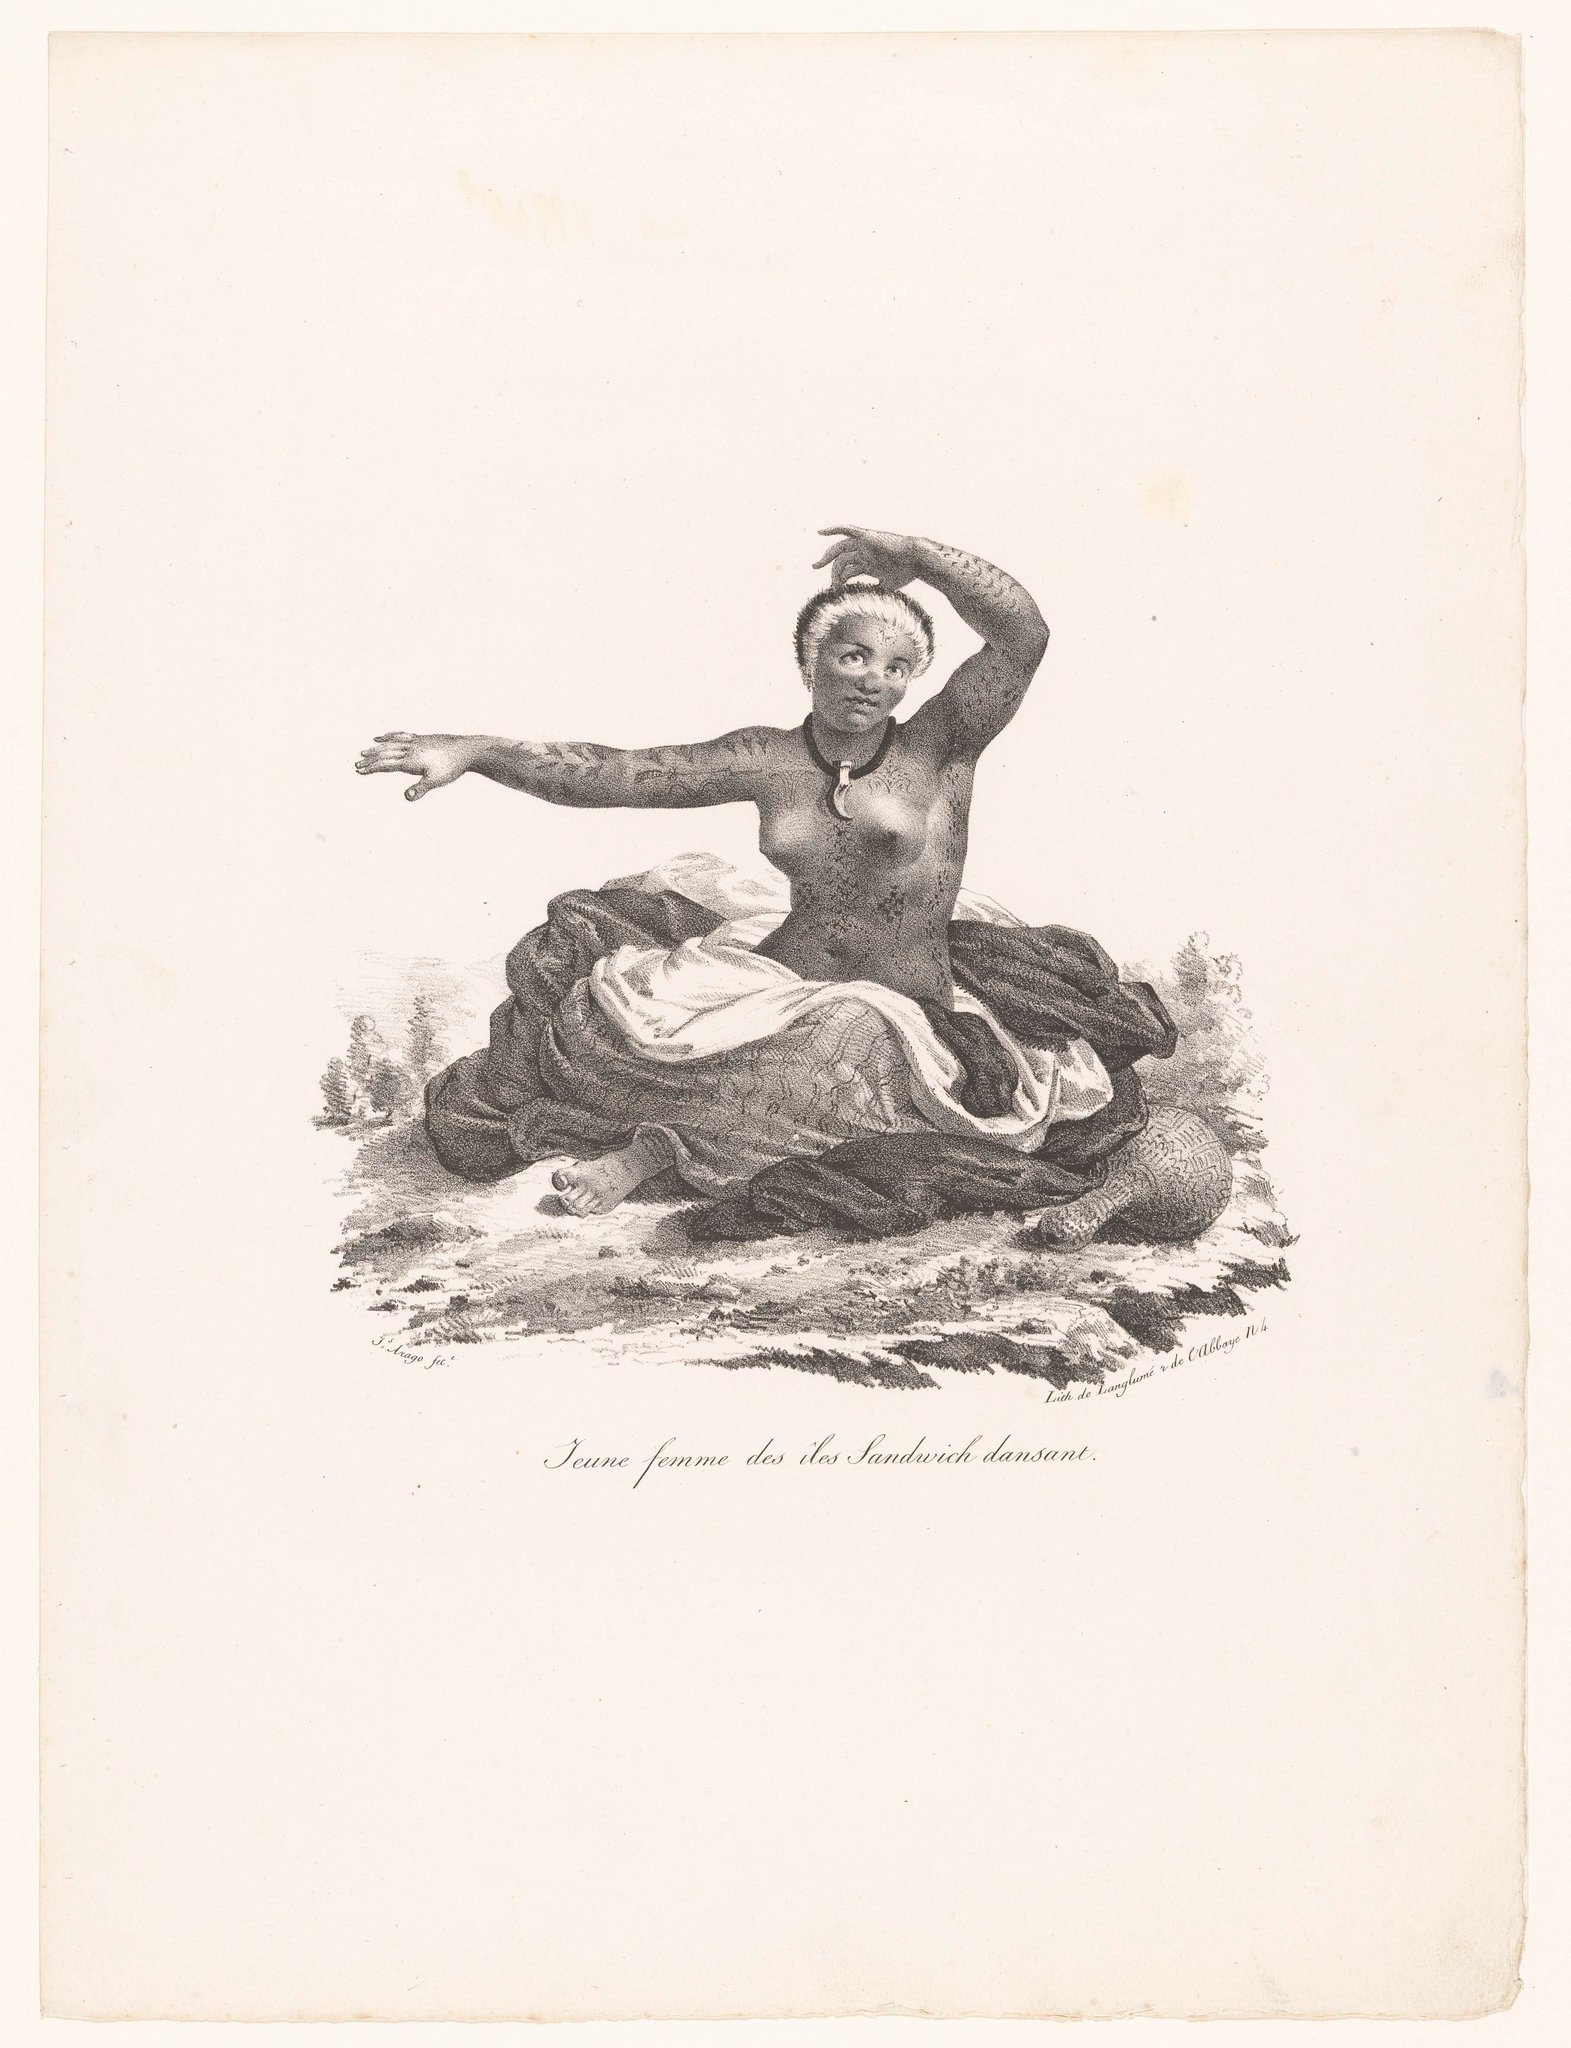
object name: print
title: Jeune femme des îles Sandwich dansant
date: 1822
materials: paper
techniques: lithograph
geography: paris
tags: woman dancing alone, australian and oceanian races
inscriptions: collector's mark: Lugt 2228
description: Prent mogelijk uit een album dat is uitgegeven bij: Arago, J.E.V. Promenade autour de monde pendant les années 1817, 1818, 1819 et 1820, sur les corvettes du roi l'Uranie et la Physicienne, commandées par M. Freycinet. 2 dln. Parijs: Leblanc, 1822.